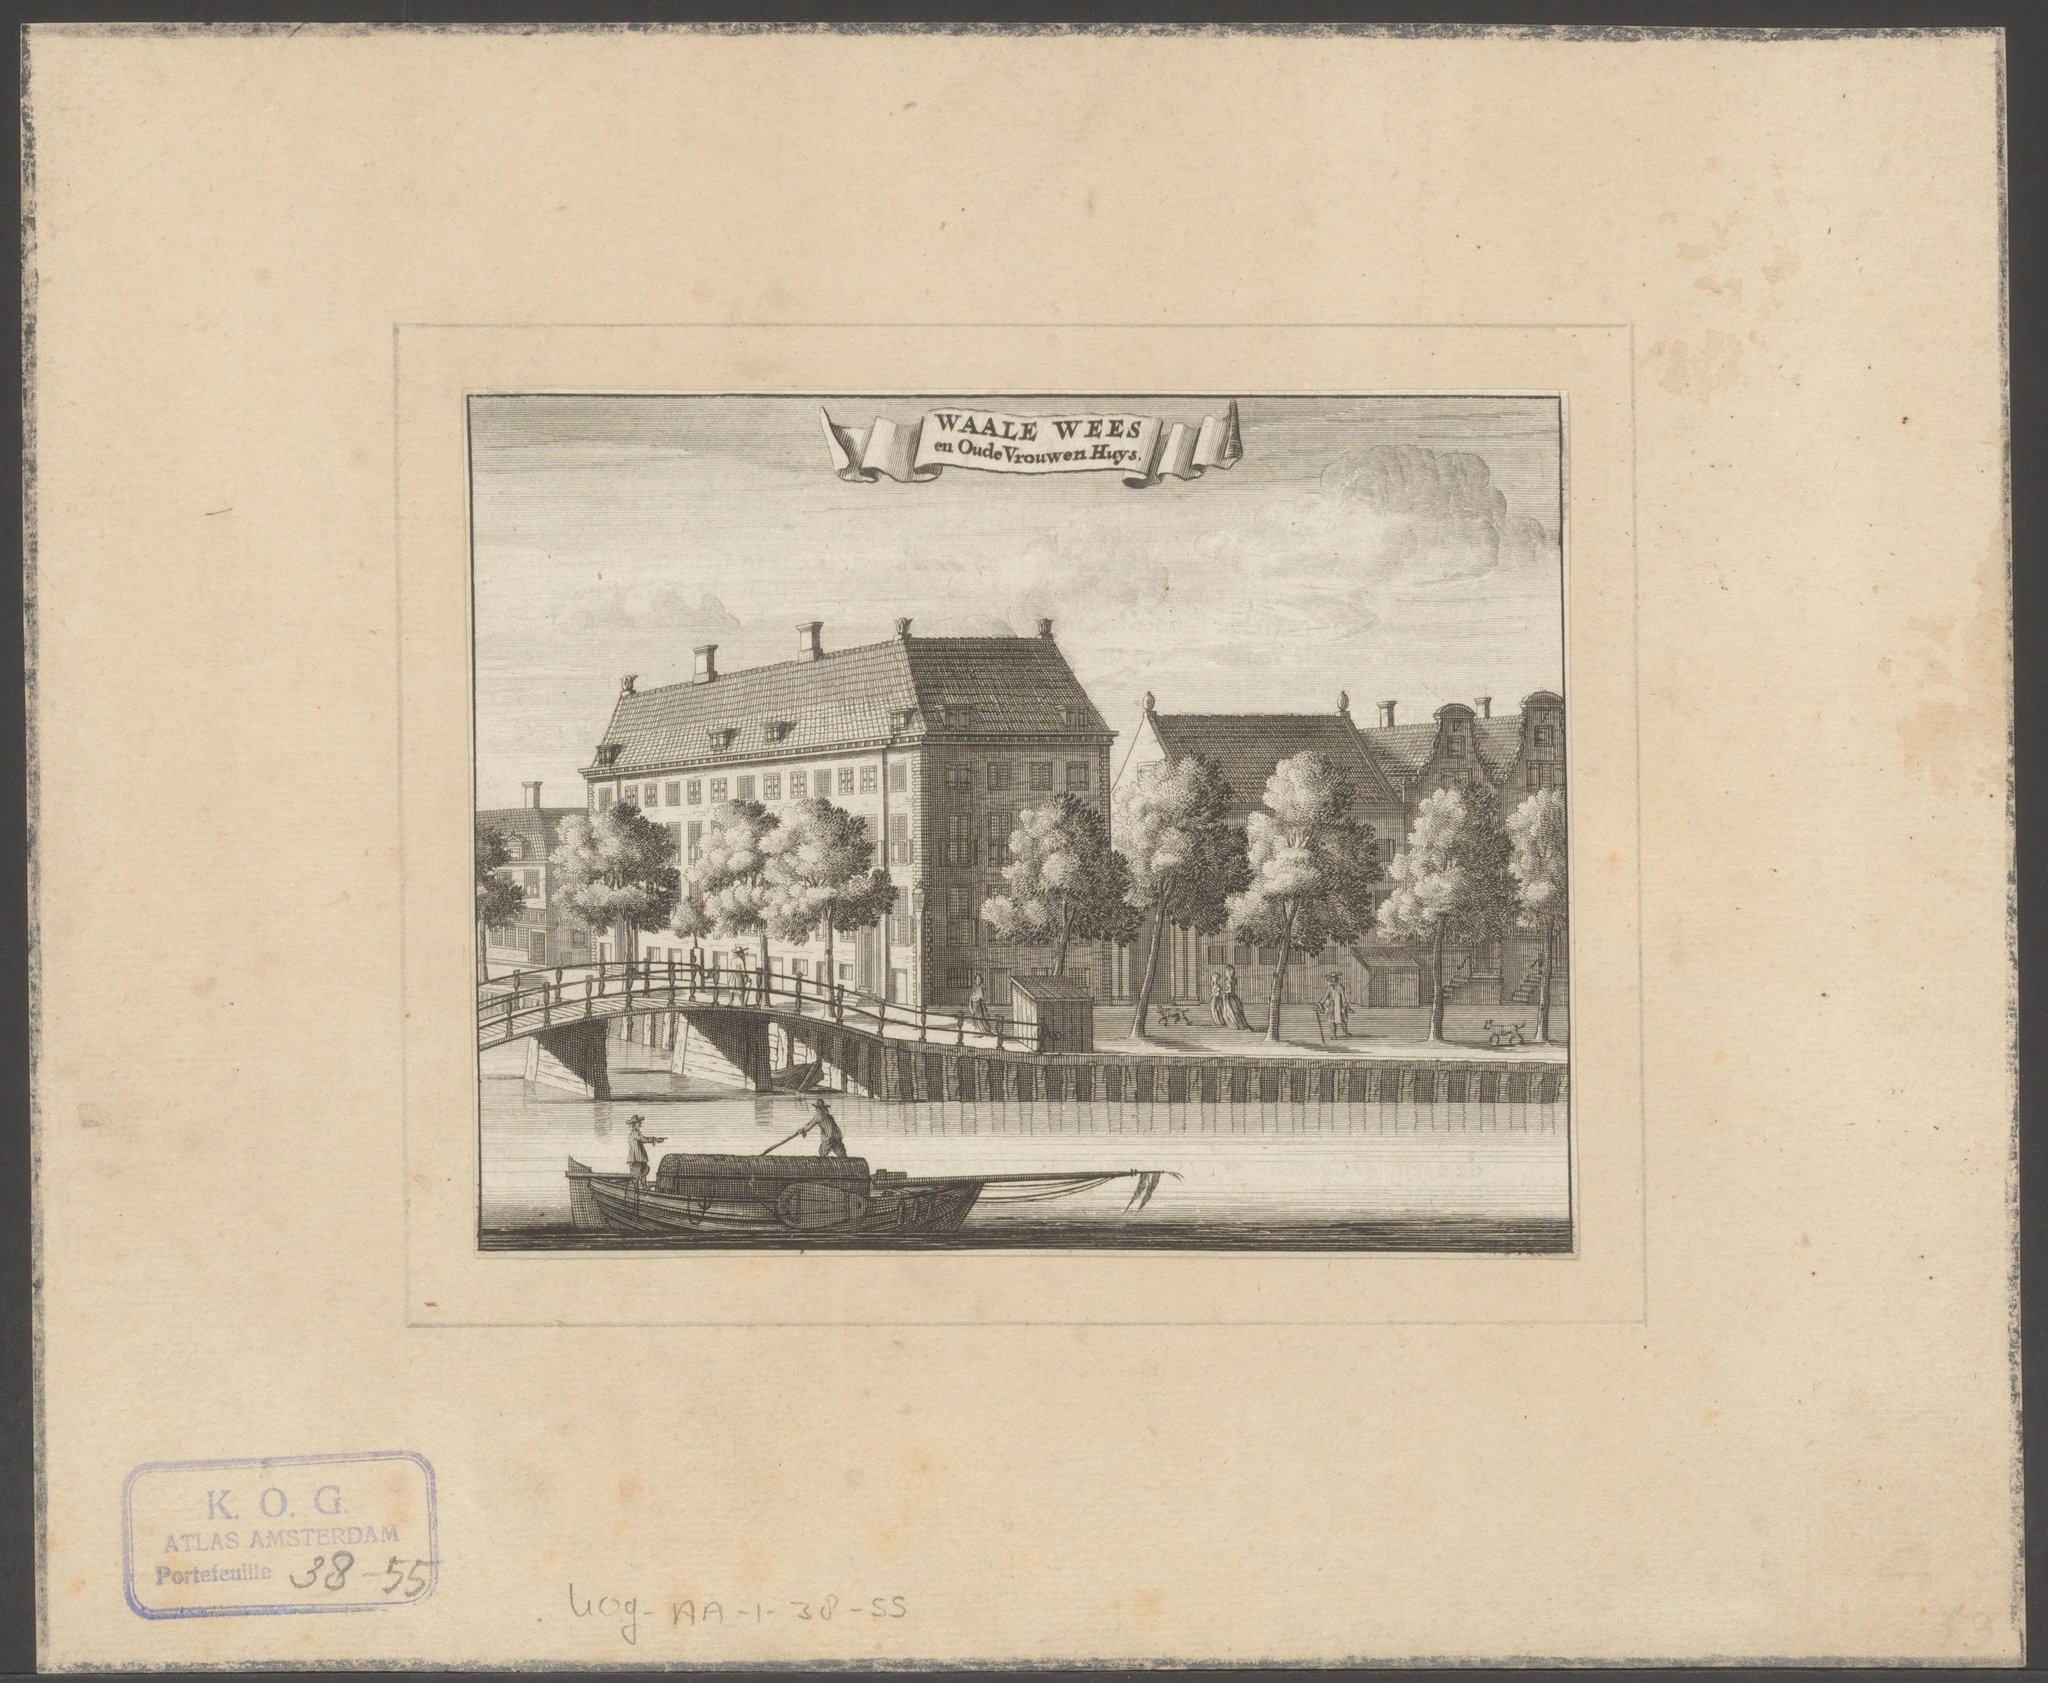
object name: print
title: Waale Wees en Oude Vrouwen Huys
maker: Anonymous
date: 1693-1694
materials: paper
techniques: engraving, etching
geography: northern netherlands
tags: bridge in city across river, canal, etc. (+ city(-scape) with figures, staffage), rowing-boat, canoe, etc., orphanage, canals, waters (in city) (+ city(-scape) with figures, staffage)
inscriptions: collector's mark: Lugt 1641b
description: Huidige staat van prent ook gebruikt in: Commelin, Casparus. Beschryvinge van Amsterdam (…). Amsterdam: Abraham Wolfgang, Gillis Janssonius van Waesberge of Johannes Janssonius van Waesberge, Hendrick Boom of weduwe Dirk Boom, Abraham van Sanderen en Rembertus Goethals, 1693, dl. 2, p. 605. En in: Commelin, Casparus. Beschryvinge van Amsterdam (…). Amsterdam: weduwe Aart Dircksz. Oossaan, 1694, dl. 2, p. 605. Latere staat van prent (met opgewerkte lucht- en waterpartijen) ook gebruikt in: Commelin, Casparus. Beschryvinge van Amsterdam (…). 2de druk. Amsterdam: Andries van Damme, Johannes Ratelband, weduwe Antony van Aeltwijk en Hermanus Uytwerf, 1726, dl. 2, p. 605.